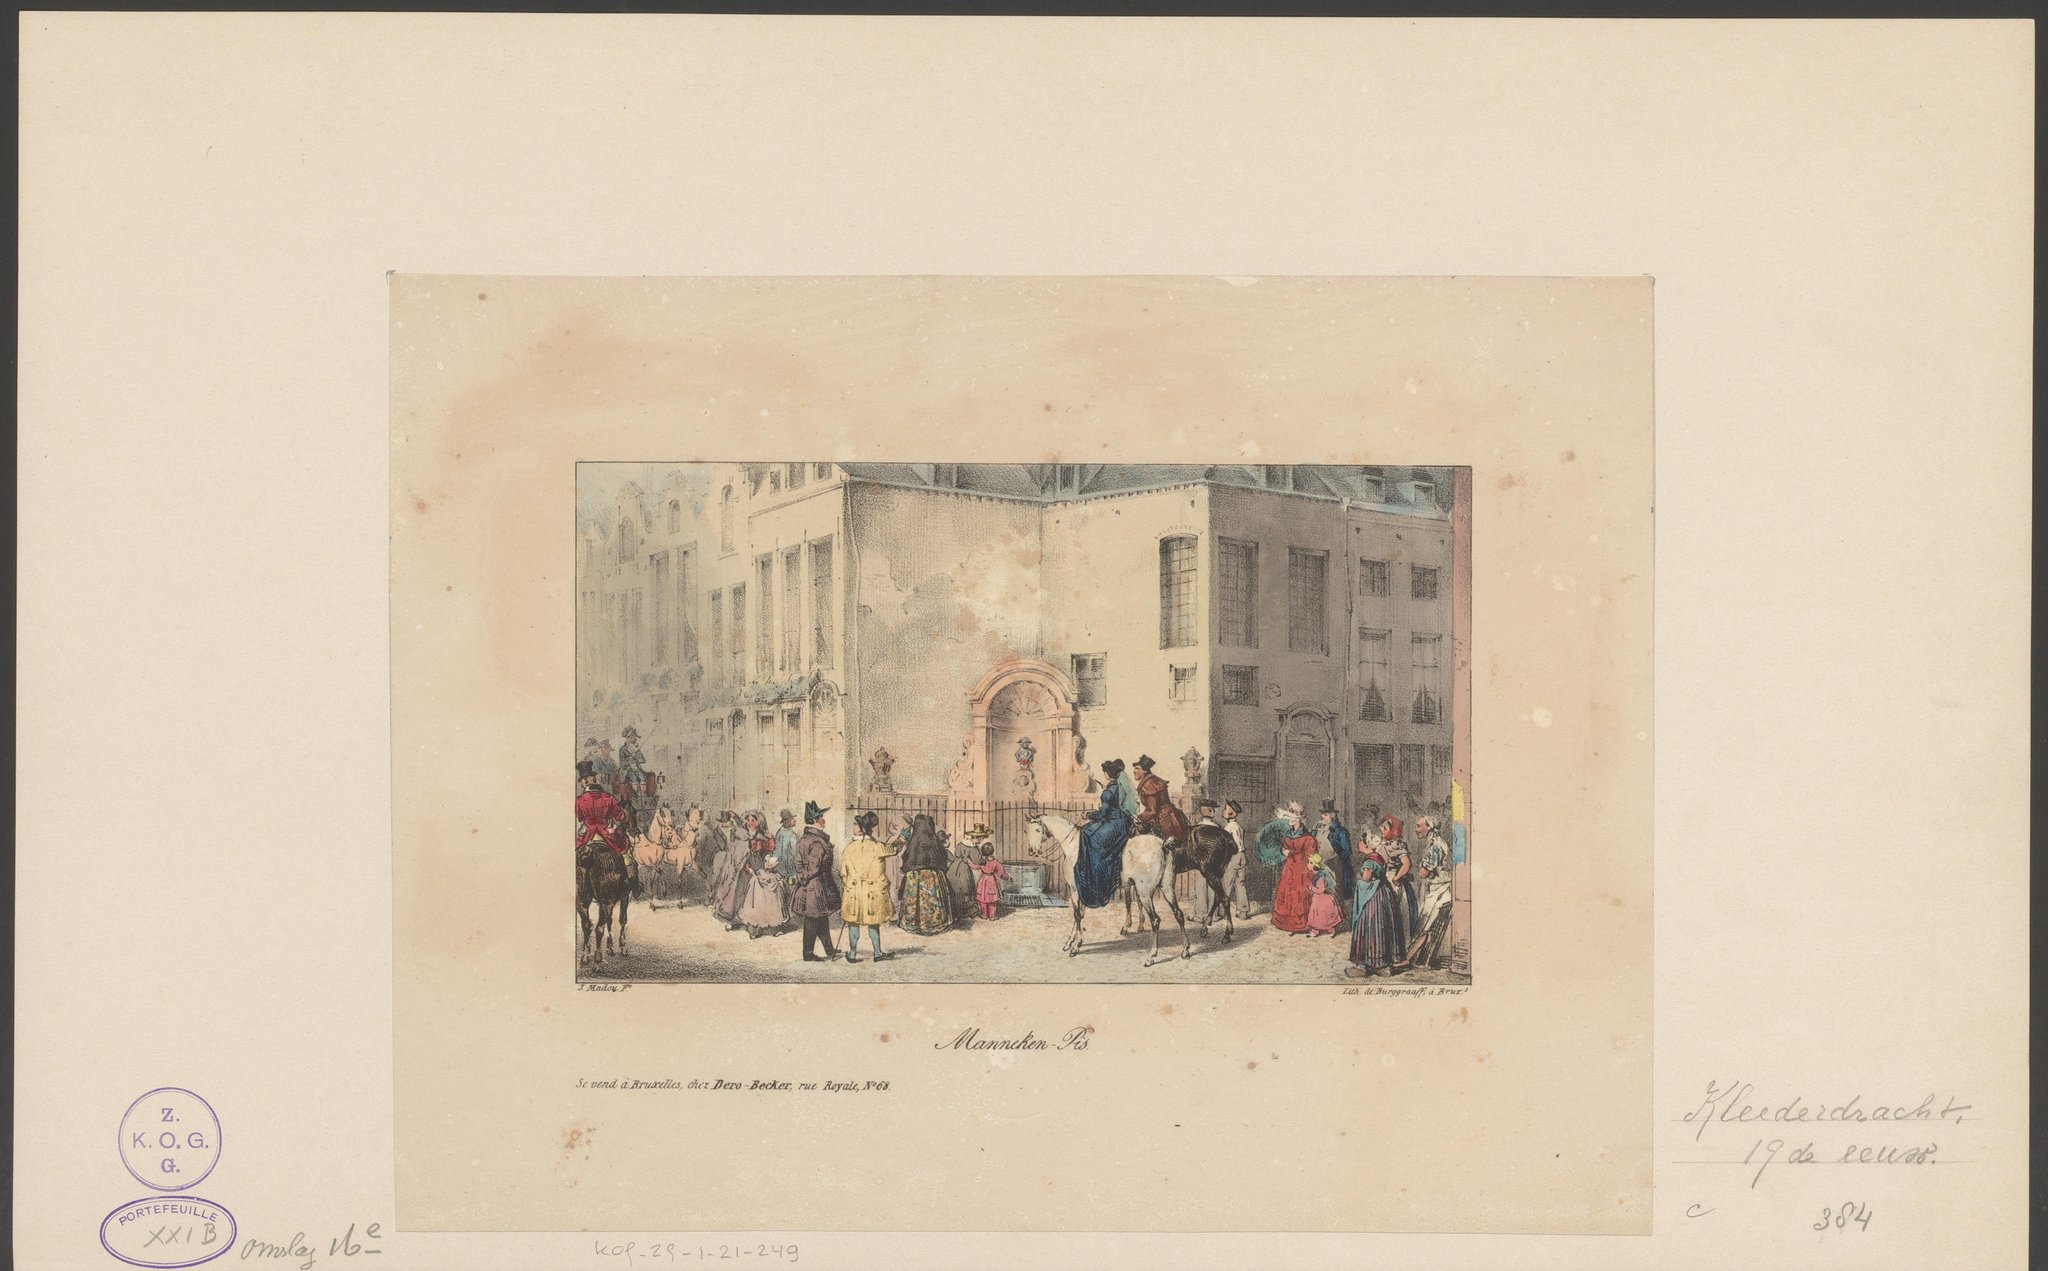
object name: print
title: Bezoekers bij Manneken Pis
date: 1827-1860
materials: paper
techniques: hand coloring, lithograph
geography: brussels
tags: tourism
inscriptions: stamp, check stamp: ‘DE’, collector's mark: Lugt 1641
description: Onderwerpsrubrieken binnen de Atlas Zeden en Gewoonten: Zeden en Gewoonten in Engeren Zin, De Kleeding, Kleederdrachten (tijdvakken), De regeering van Willem I. Mannen en vrouwen.